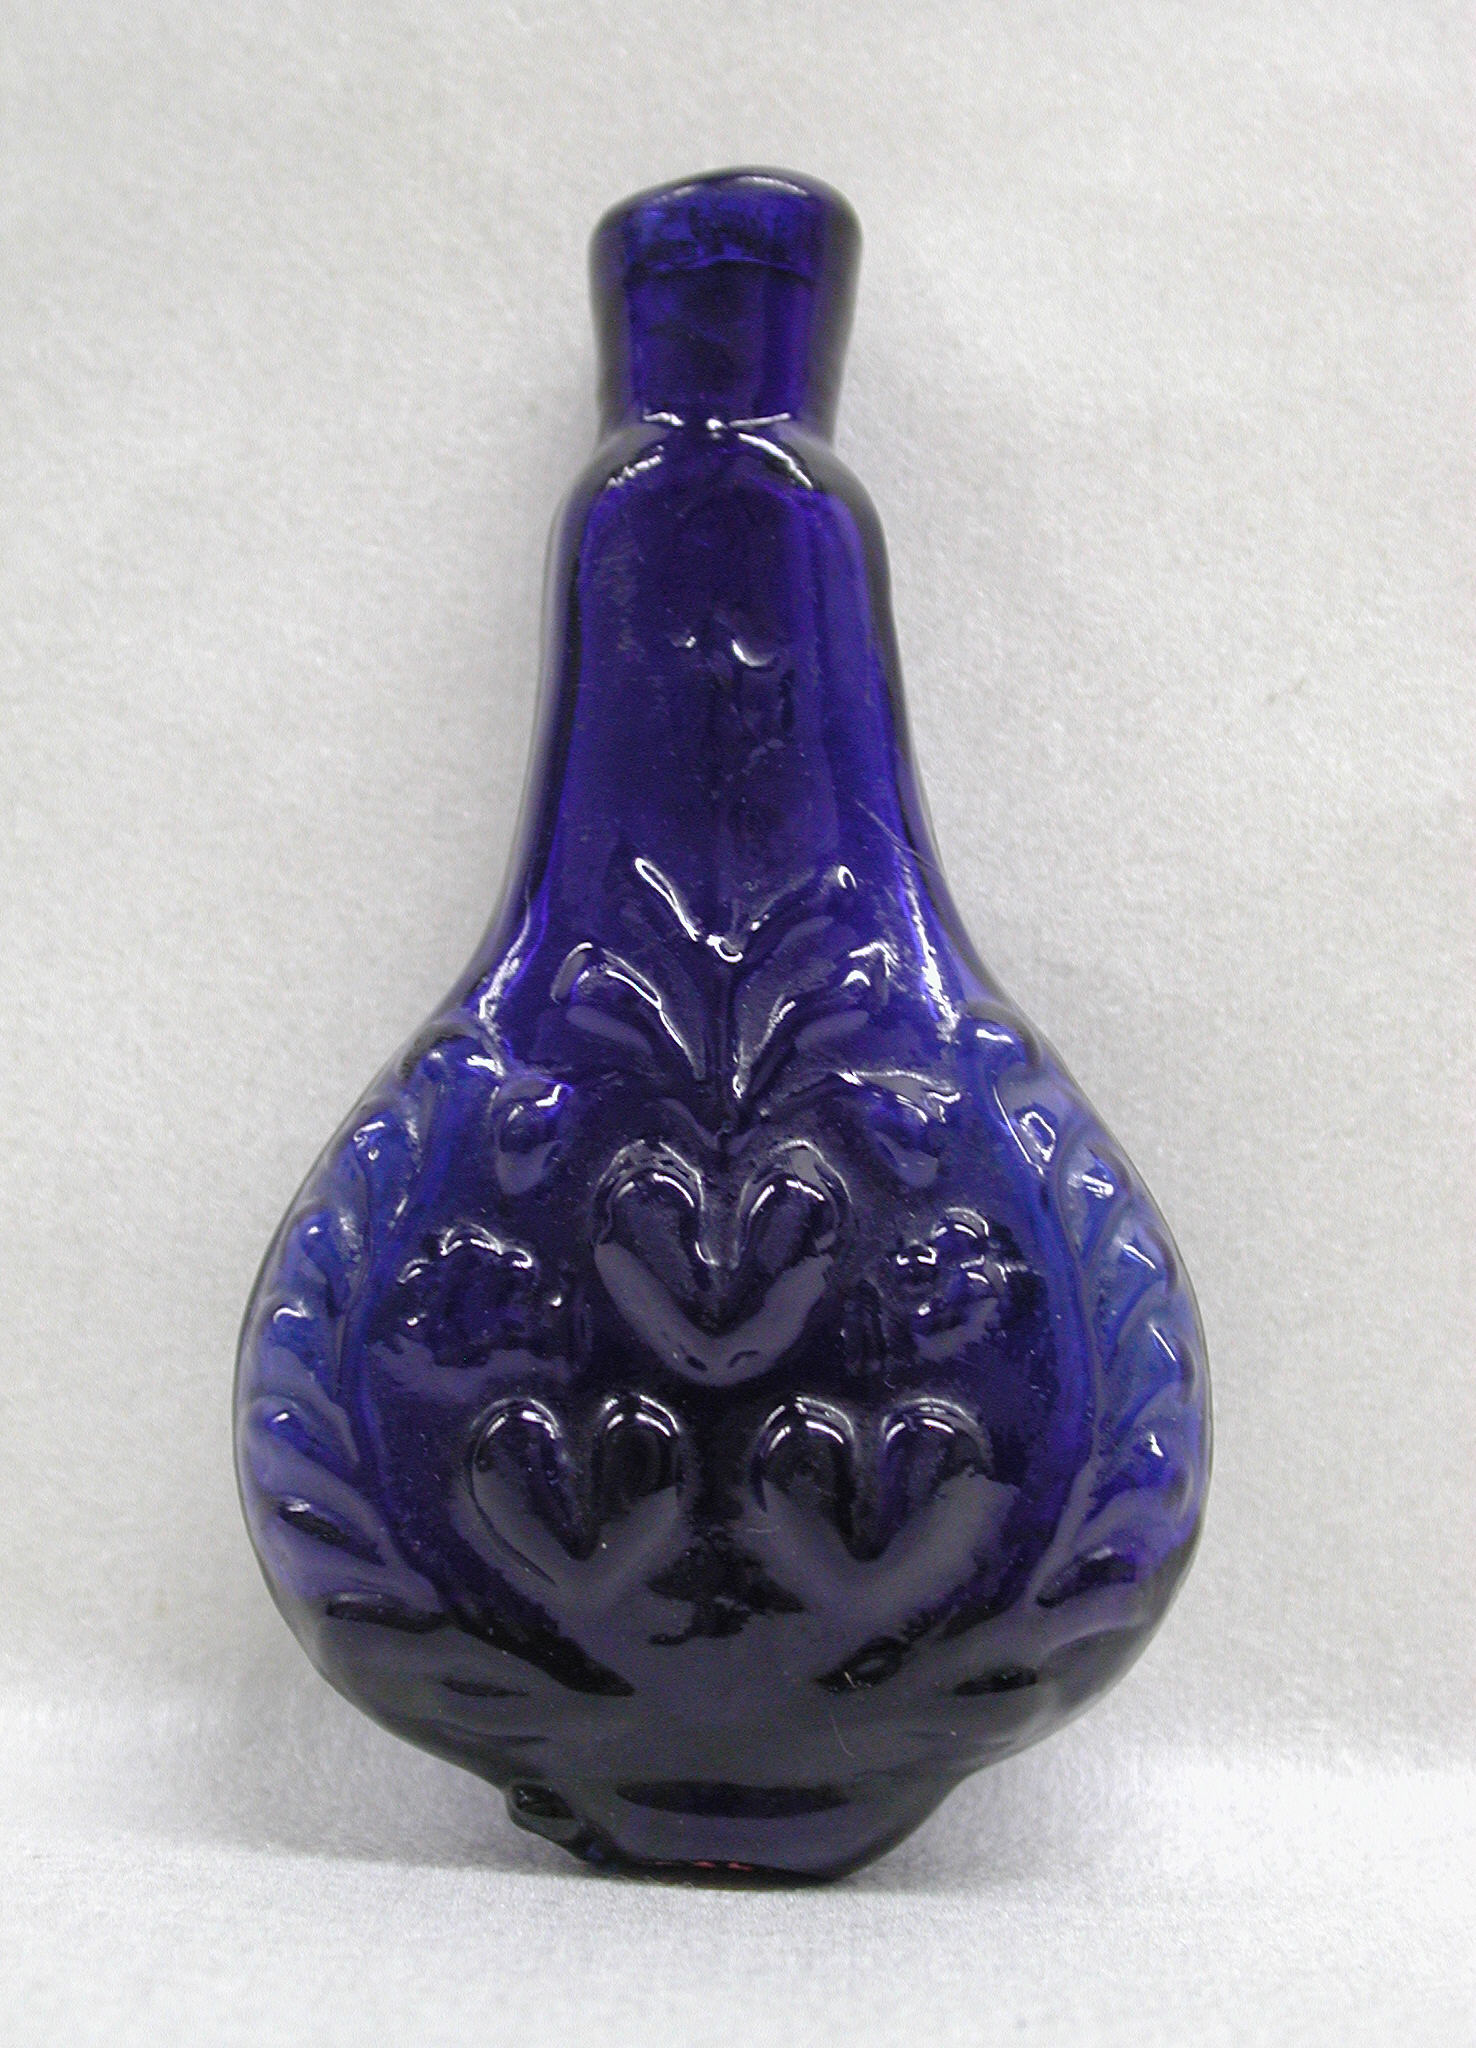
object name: scent bottle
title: Blue-colored flacon de poche decorated with fleur de lys, hearts and roses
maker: glasshouse of bernard perrot, verrerie royale d'orléans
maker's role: maker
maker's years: 1640-1709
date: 1667-1733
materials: glass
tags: roses